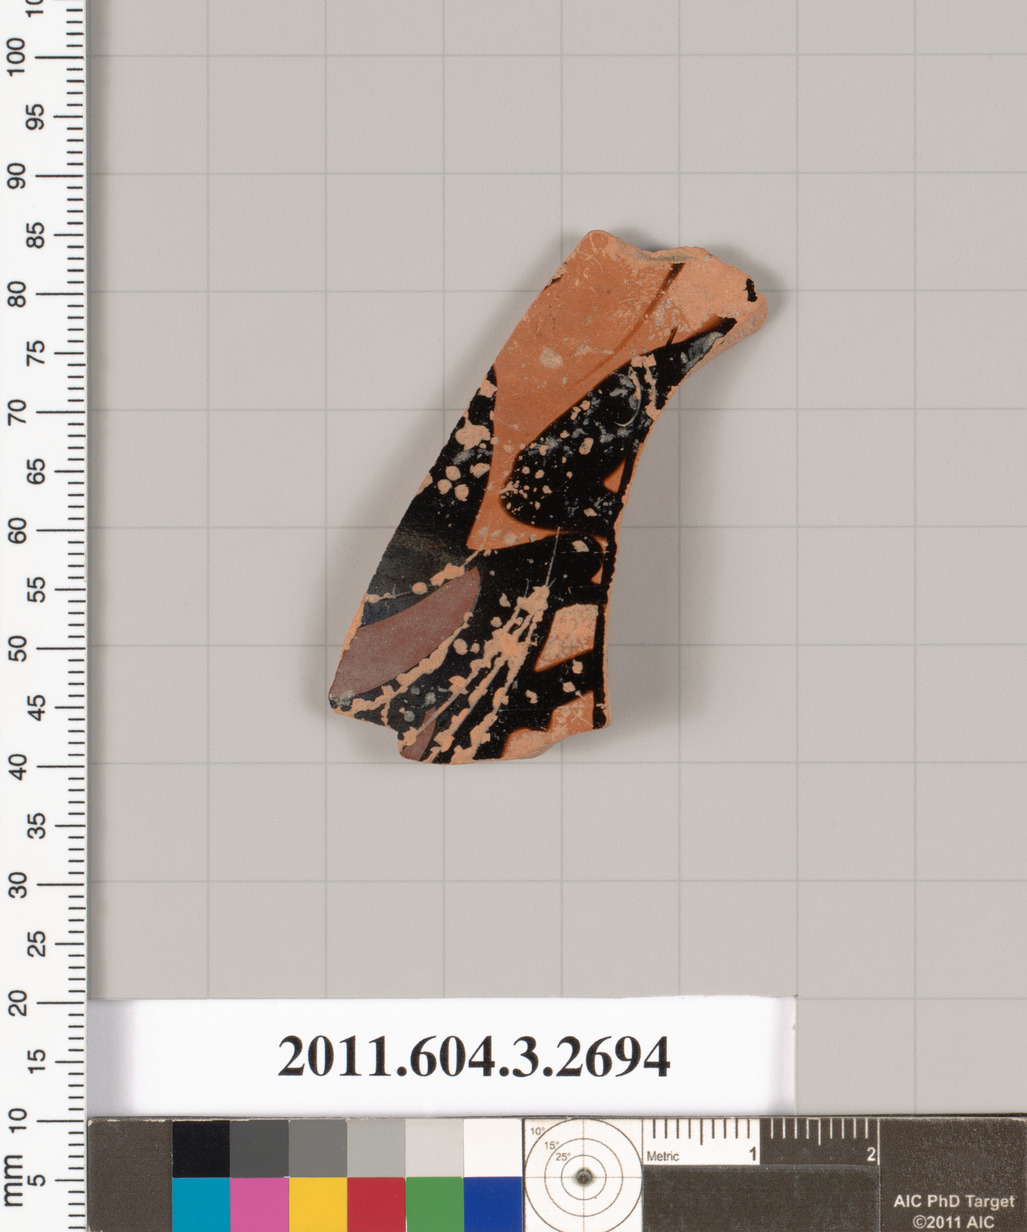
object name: olpe fragment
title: Terracotta fragment of an olpe (jug)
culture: greek, attic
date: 534-468 BCE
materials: terracotta